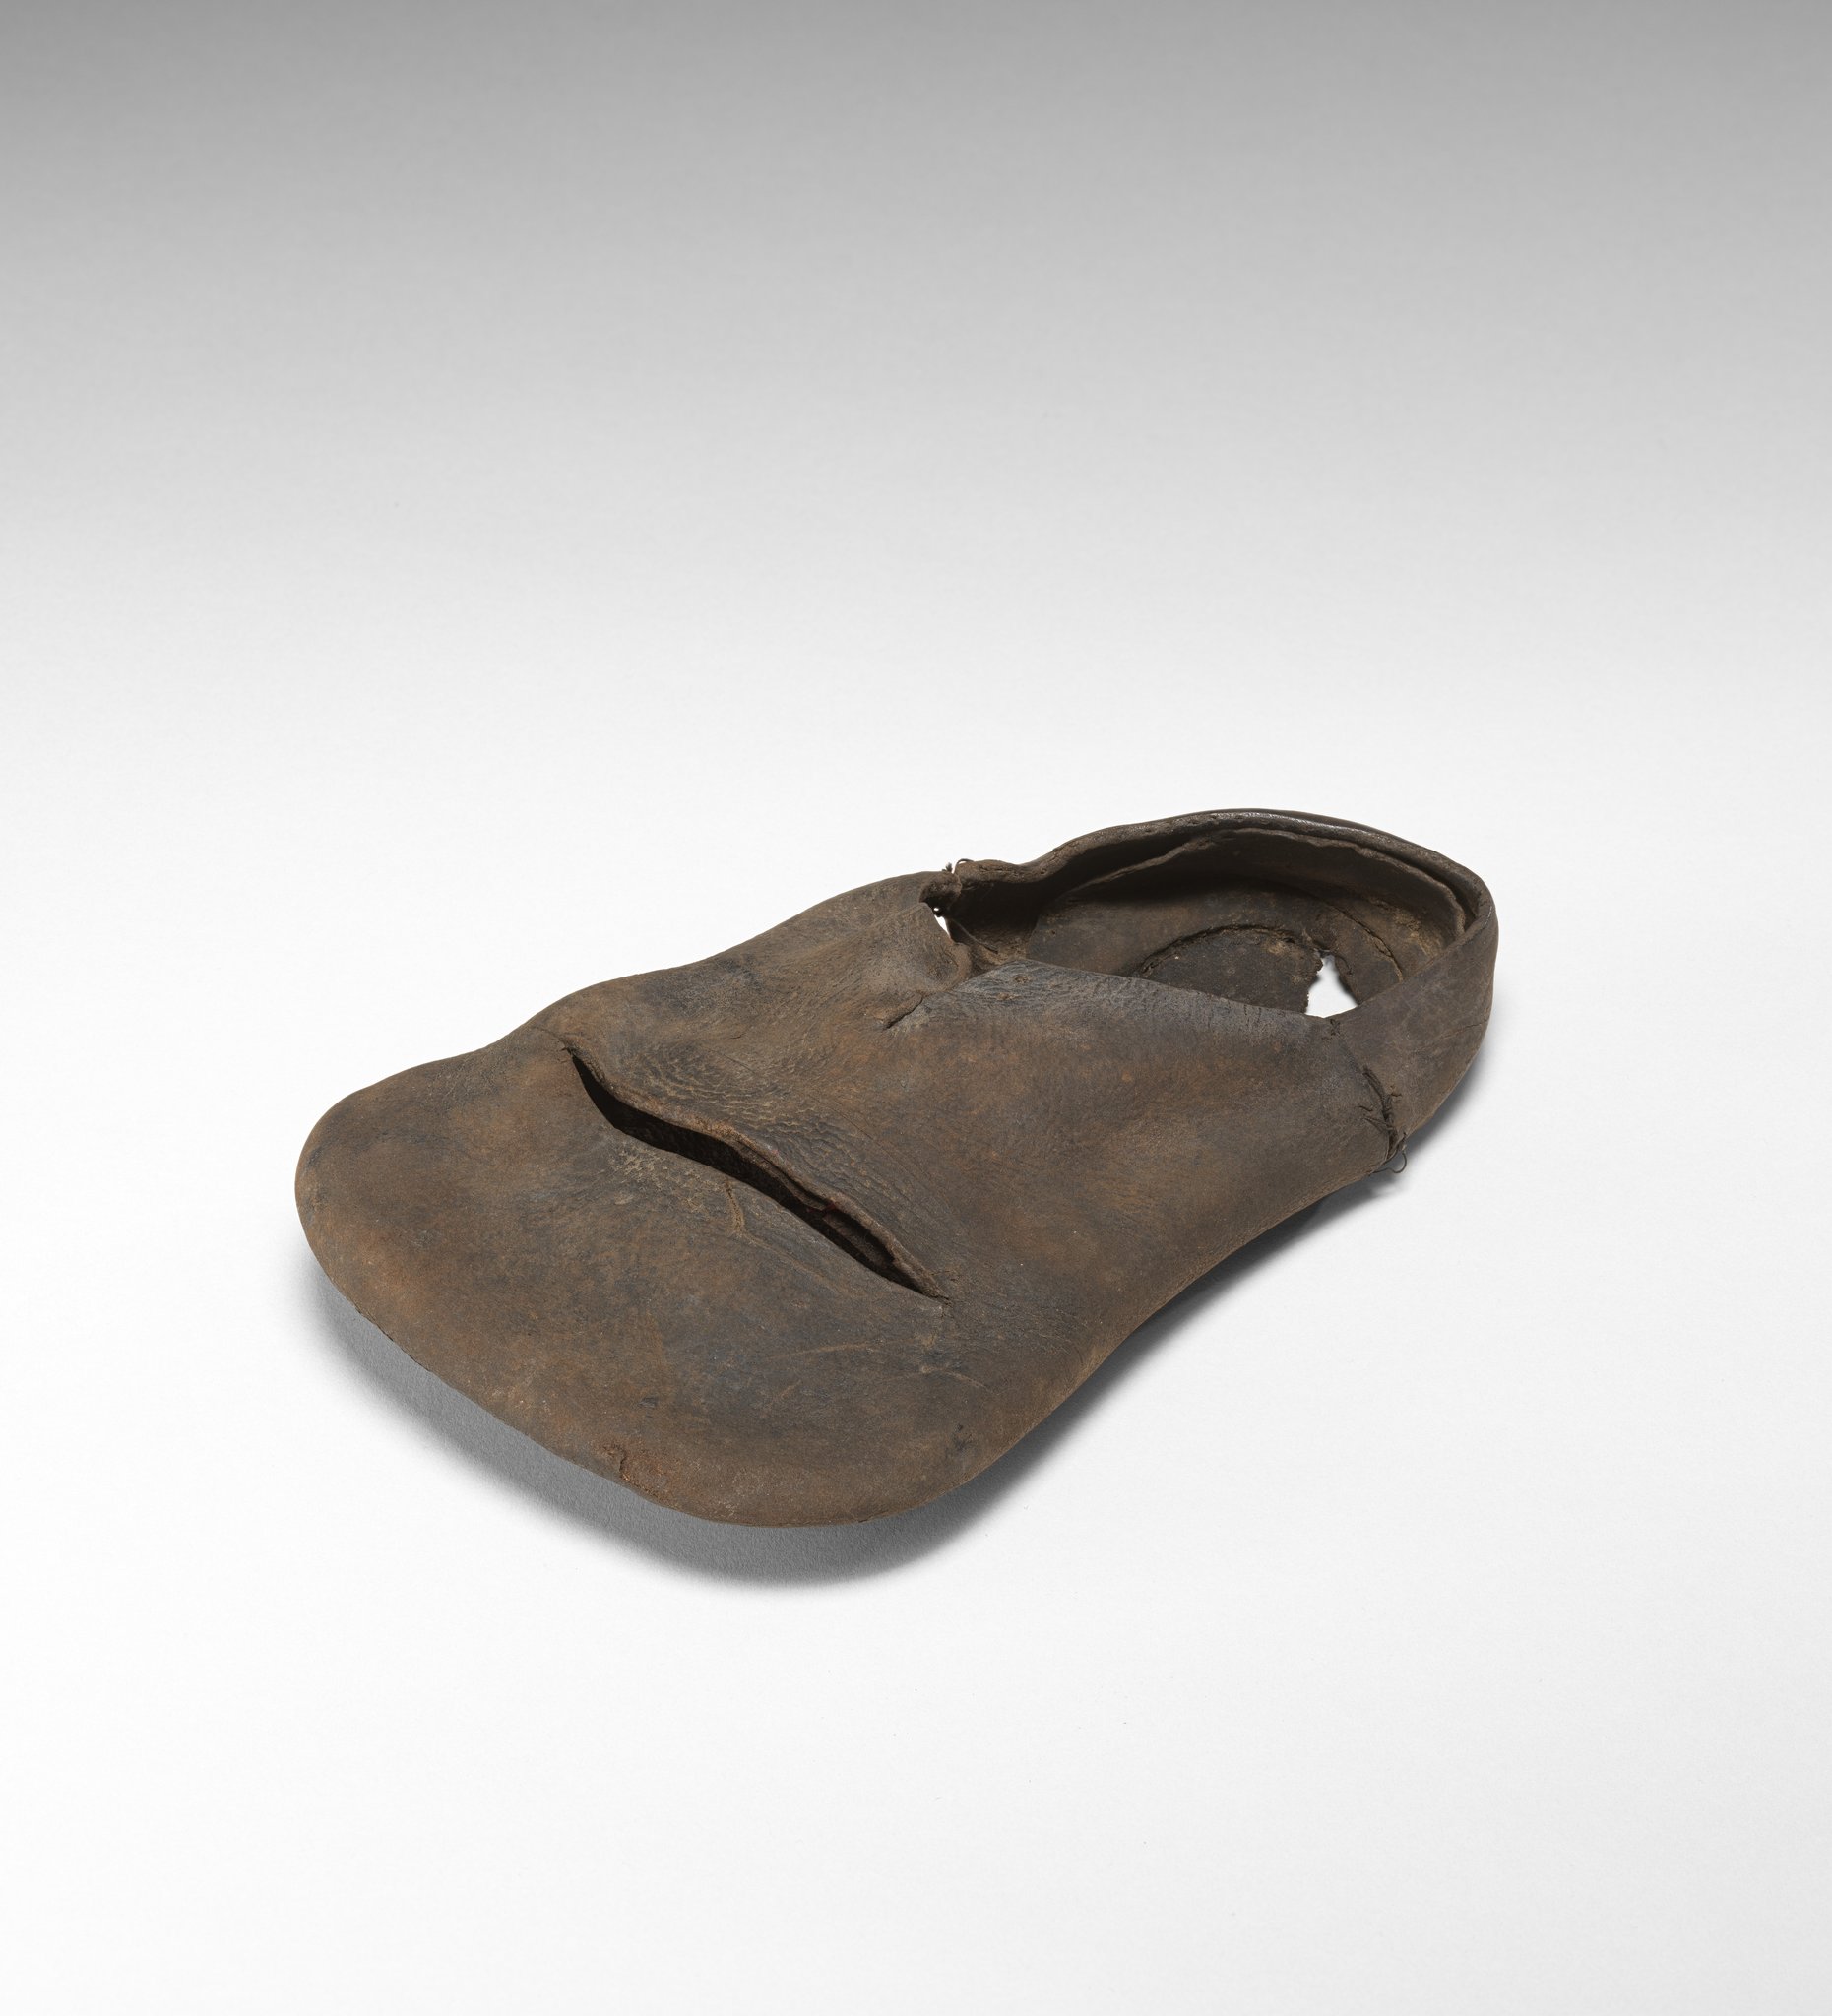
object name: shoe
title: Shoes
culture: british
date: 1501-1600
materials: leather